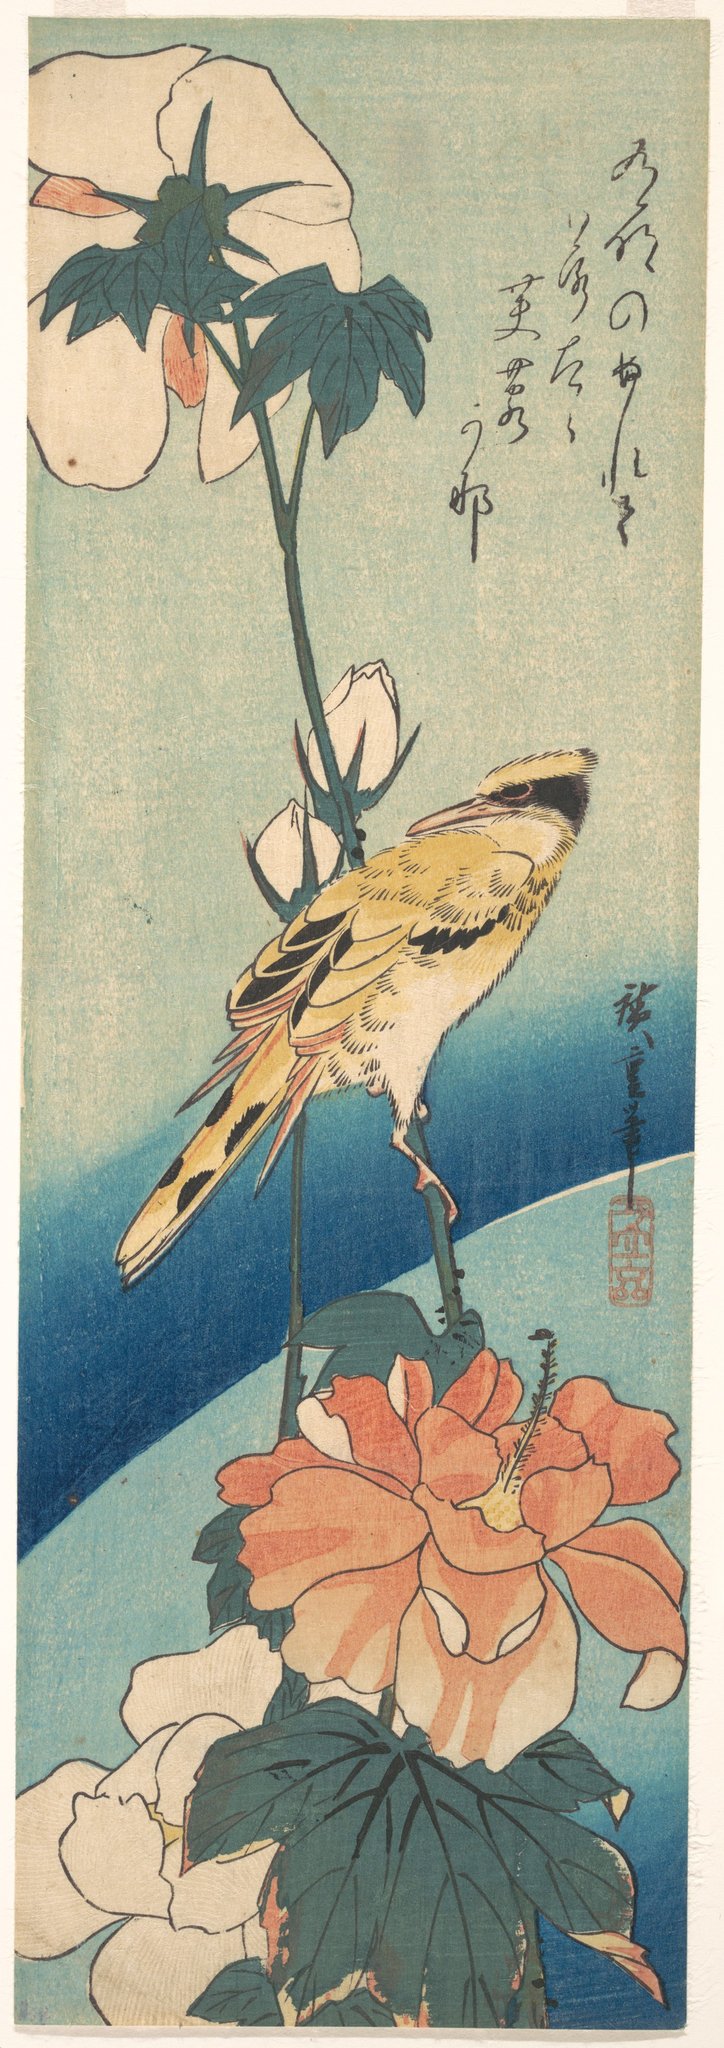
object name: print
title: A Black-Naped Oriole on a Stem of Rose Mallow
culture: japanese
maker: utagawa hiroshige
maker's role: artist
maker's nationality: japanese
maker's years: 1797-1858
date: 1834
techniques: woodblock print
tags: birds,flowers,leaves